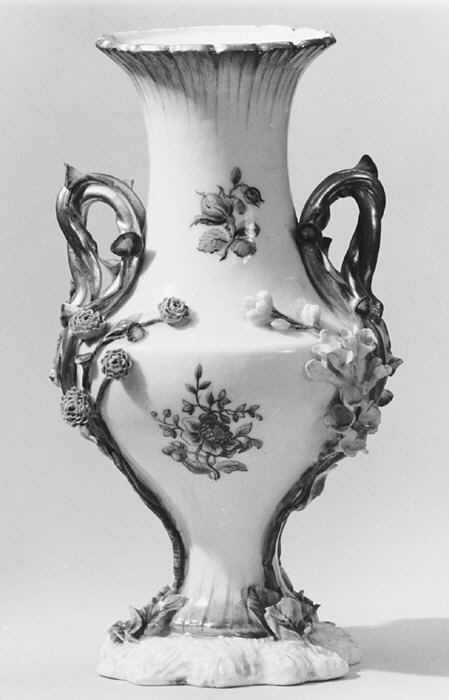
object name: vase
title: Vase (vase Duplessis) (one of a group of three)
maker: vincennes manufactory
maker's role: manufactory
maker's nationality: french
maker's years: 1740-1756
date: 1752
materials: soft paste porcelain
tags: flowers